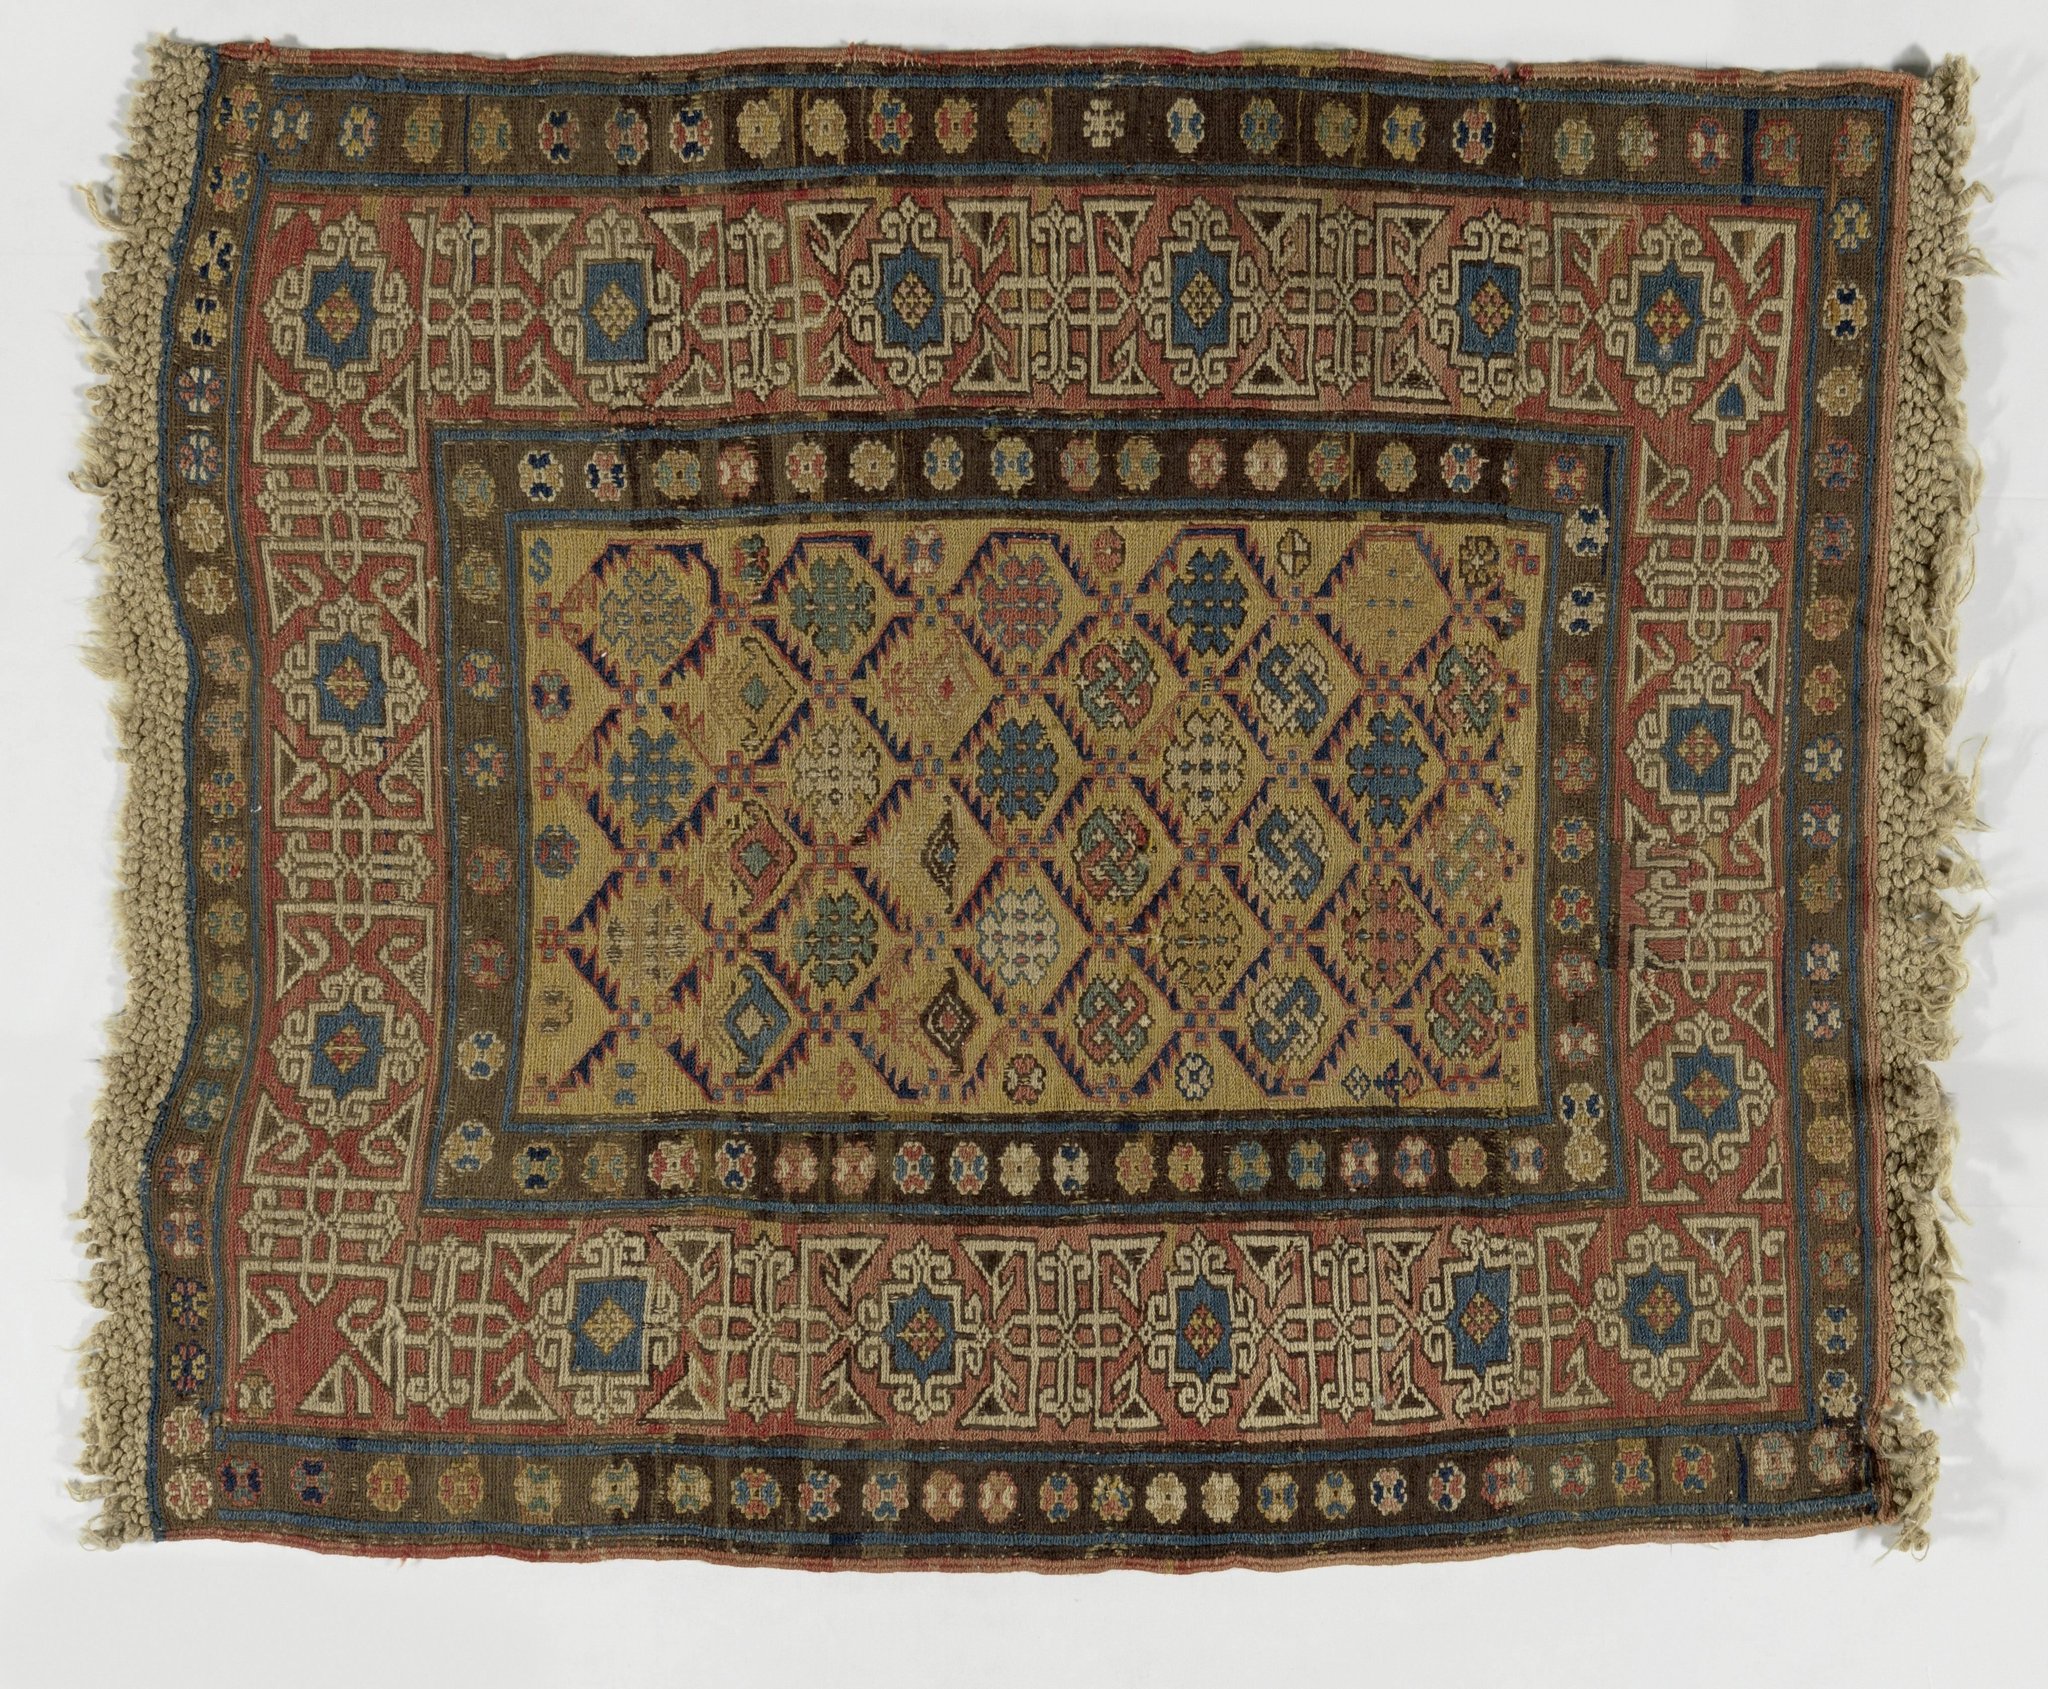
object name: oriental rug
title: Oosters tapijt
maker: Anonymous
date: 1800-1900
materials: wool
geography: east caucasus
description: Oosters tapijt, rasterwerkkleed, in soumak-techniek. Op het middenveld staat een rasterwerk van gezaagtande ranken tegen een geel fond. Binnen elke maas staat een vlechtband- of knoopmotief. Drievoudige rand, waarvan de breedste versierd is met kufische motieven. Boven- en onderaan franje. Het kleed is ingekort.